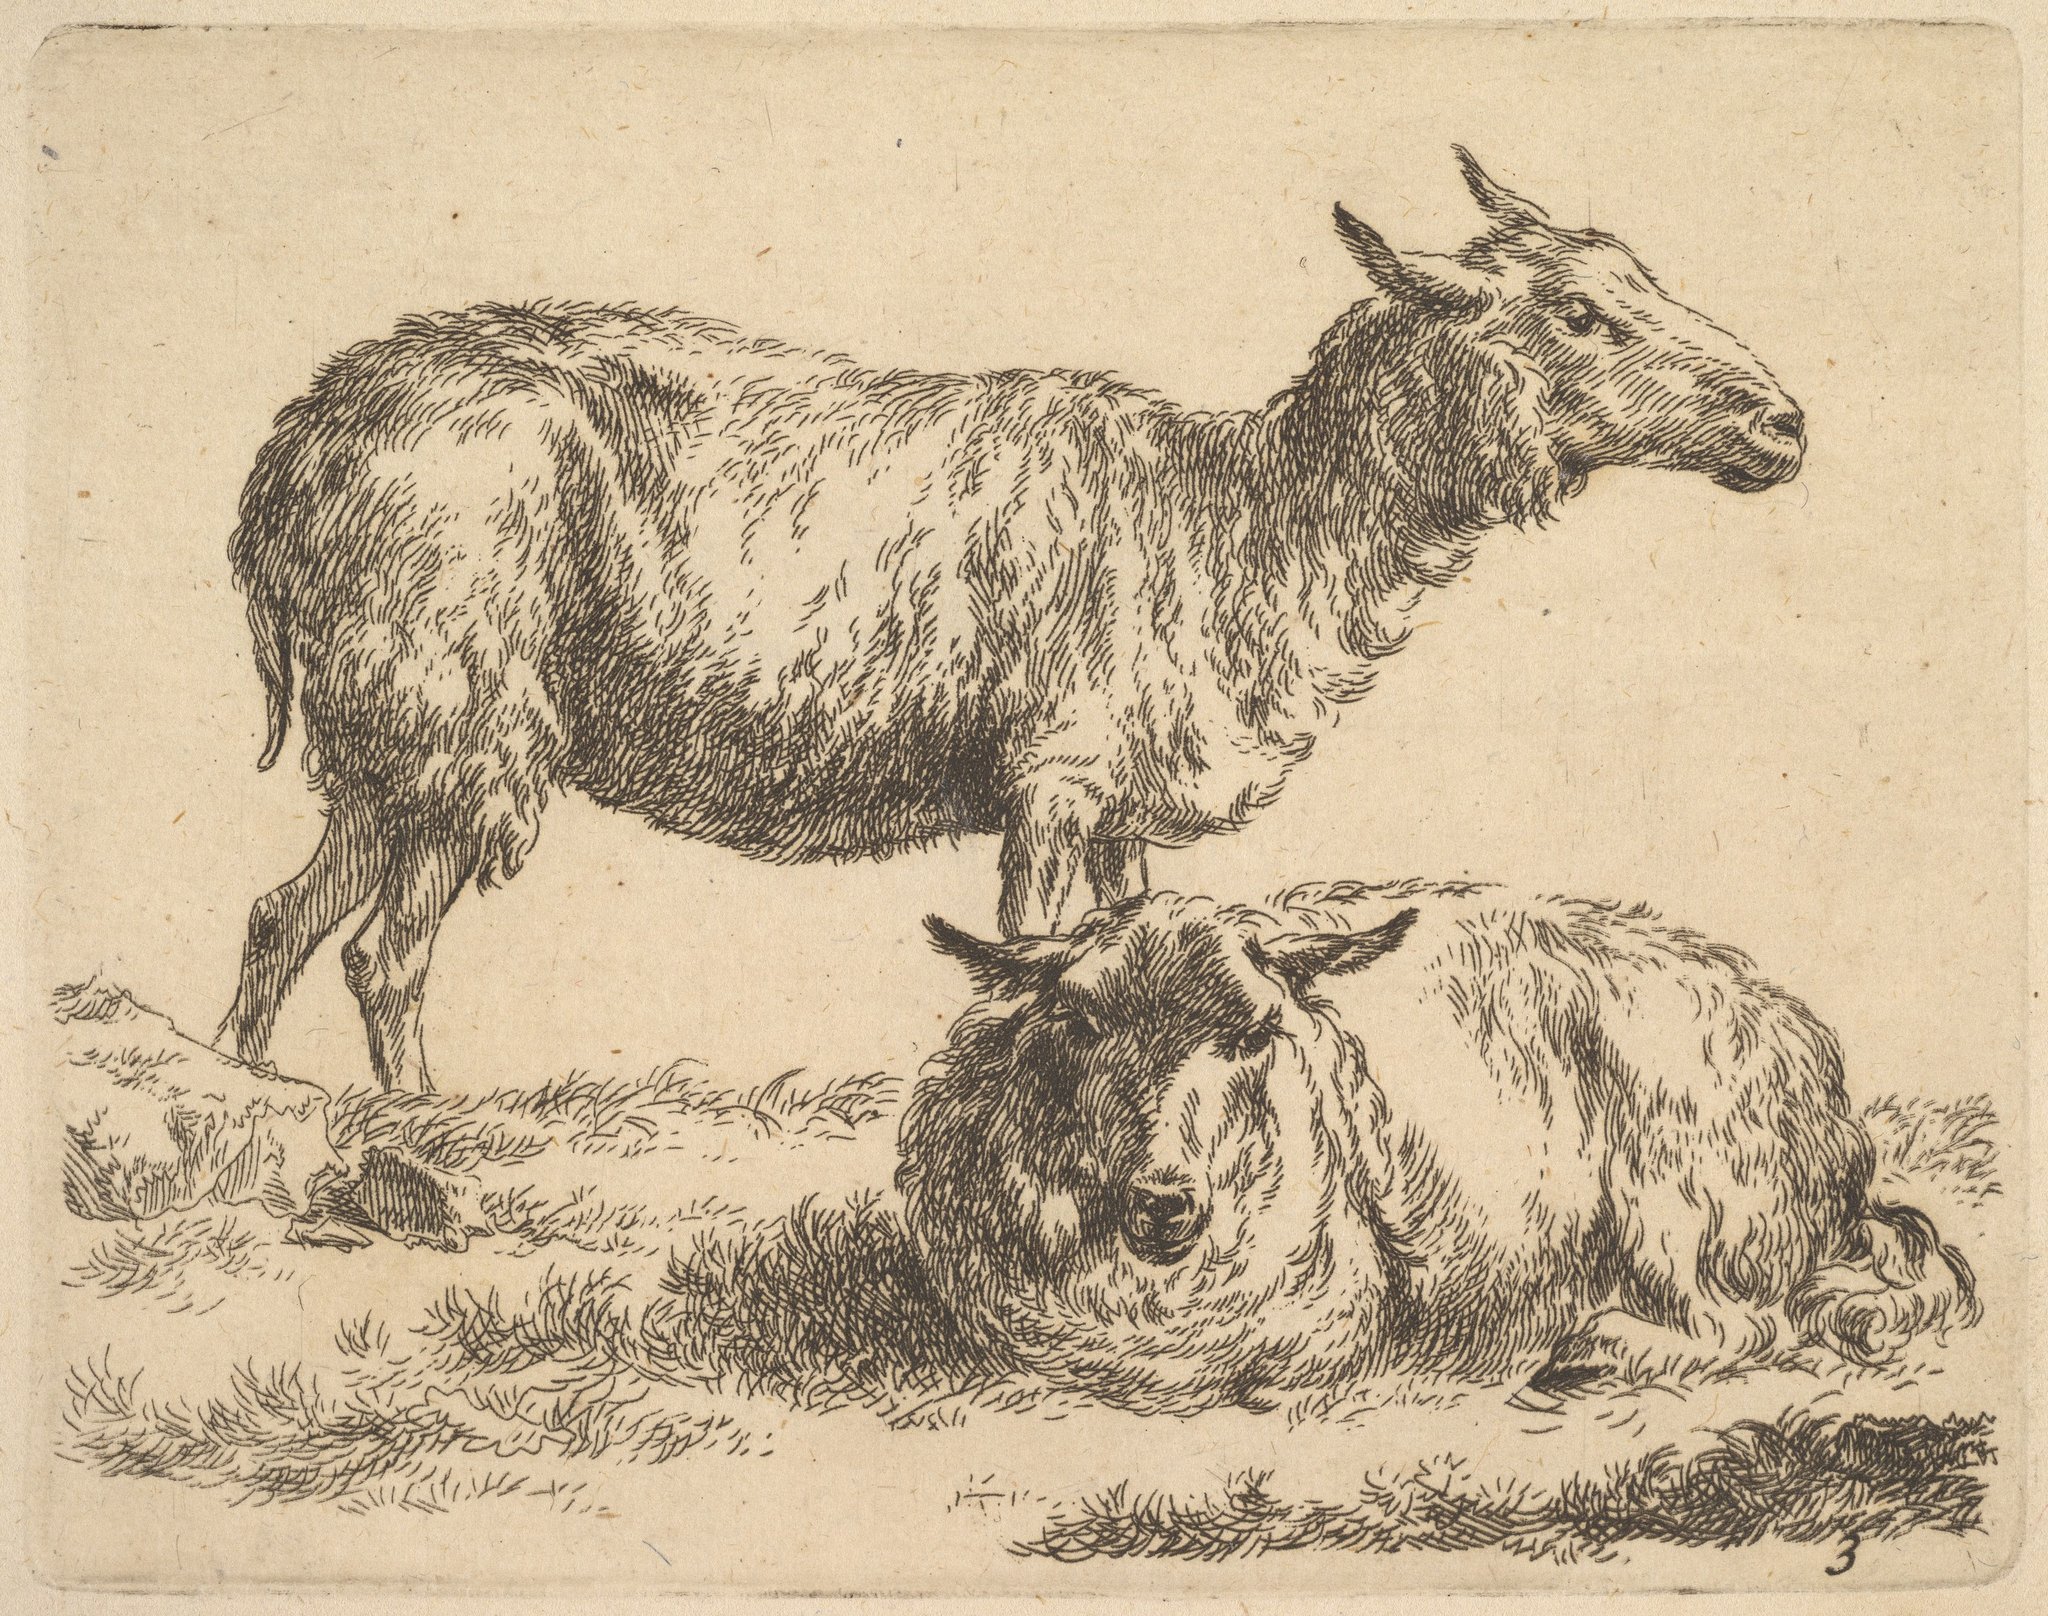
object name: print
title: Plate from "The Set of Sheep"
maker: nicolaes pietersz berchem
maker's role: artist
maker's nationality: dutch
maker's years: 1620-1683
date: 1635-1683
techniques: etching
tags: sheep